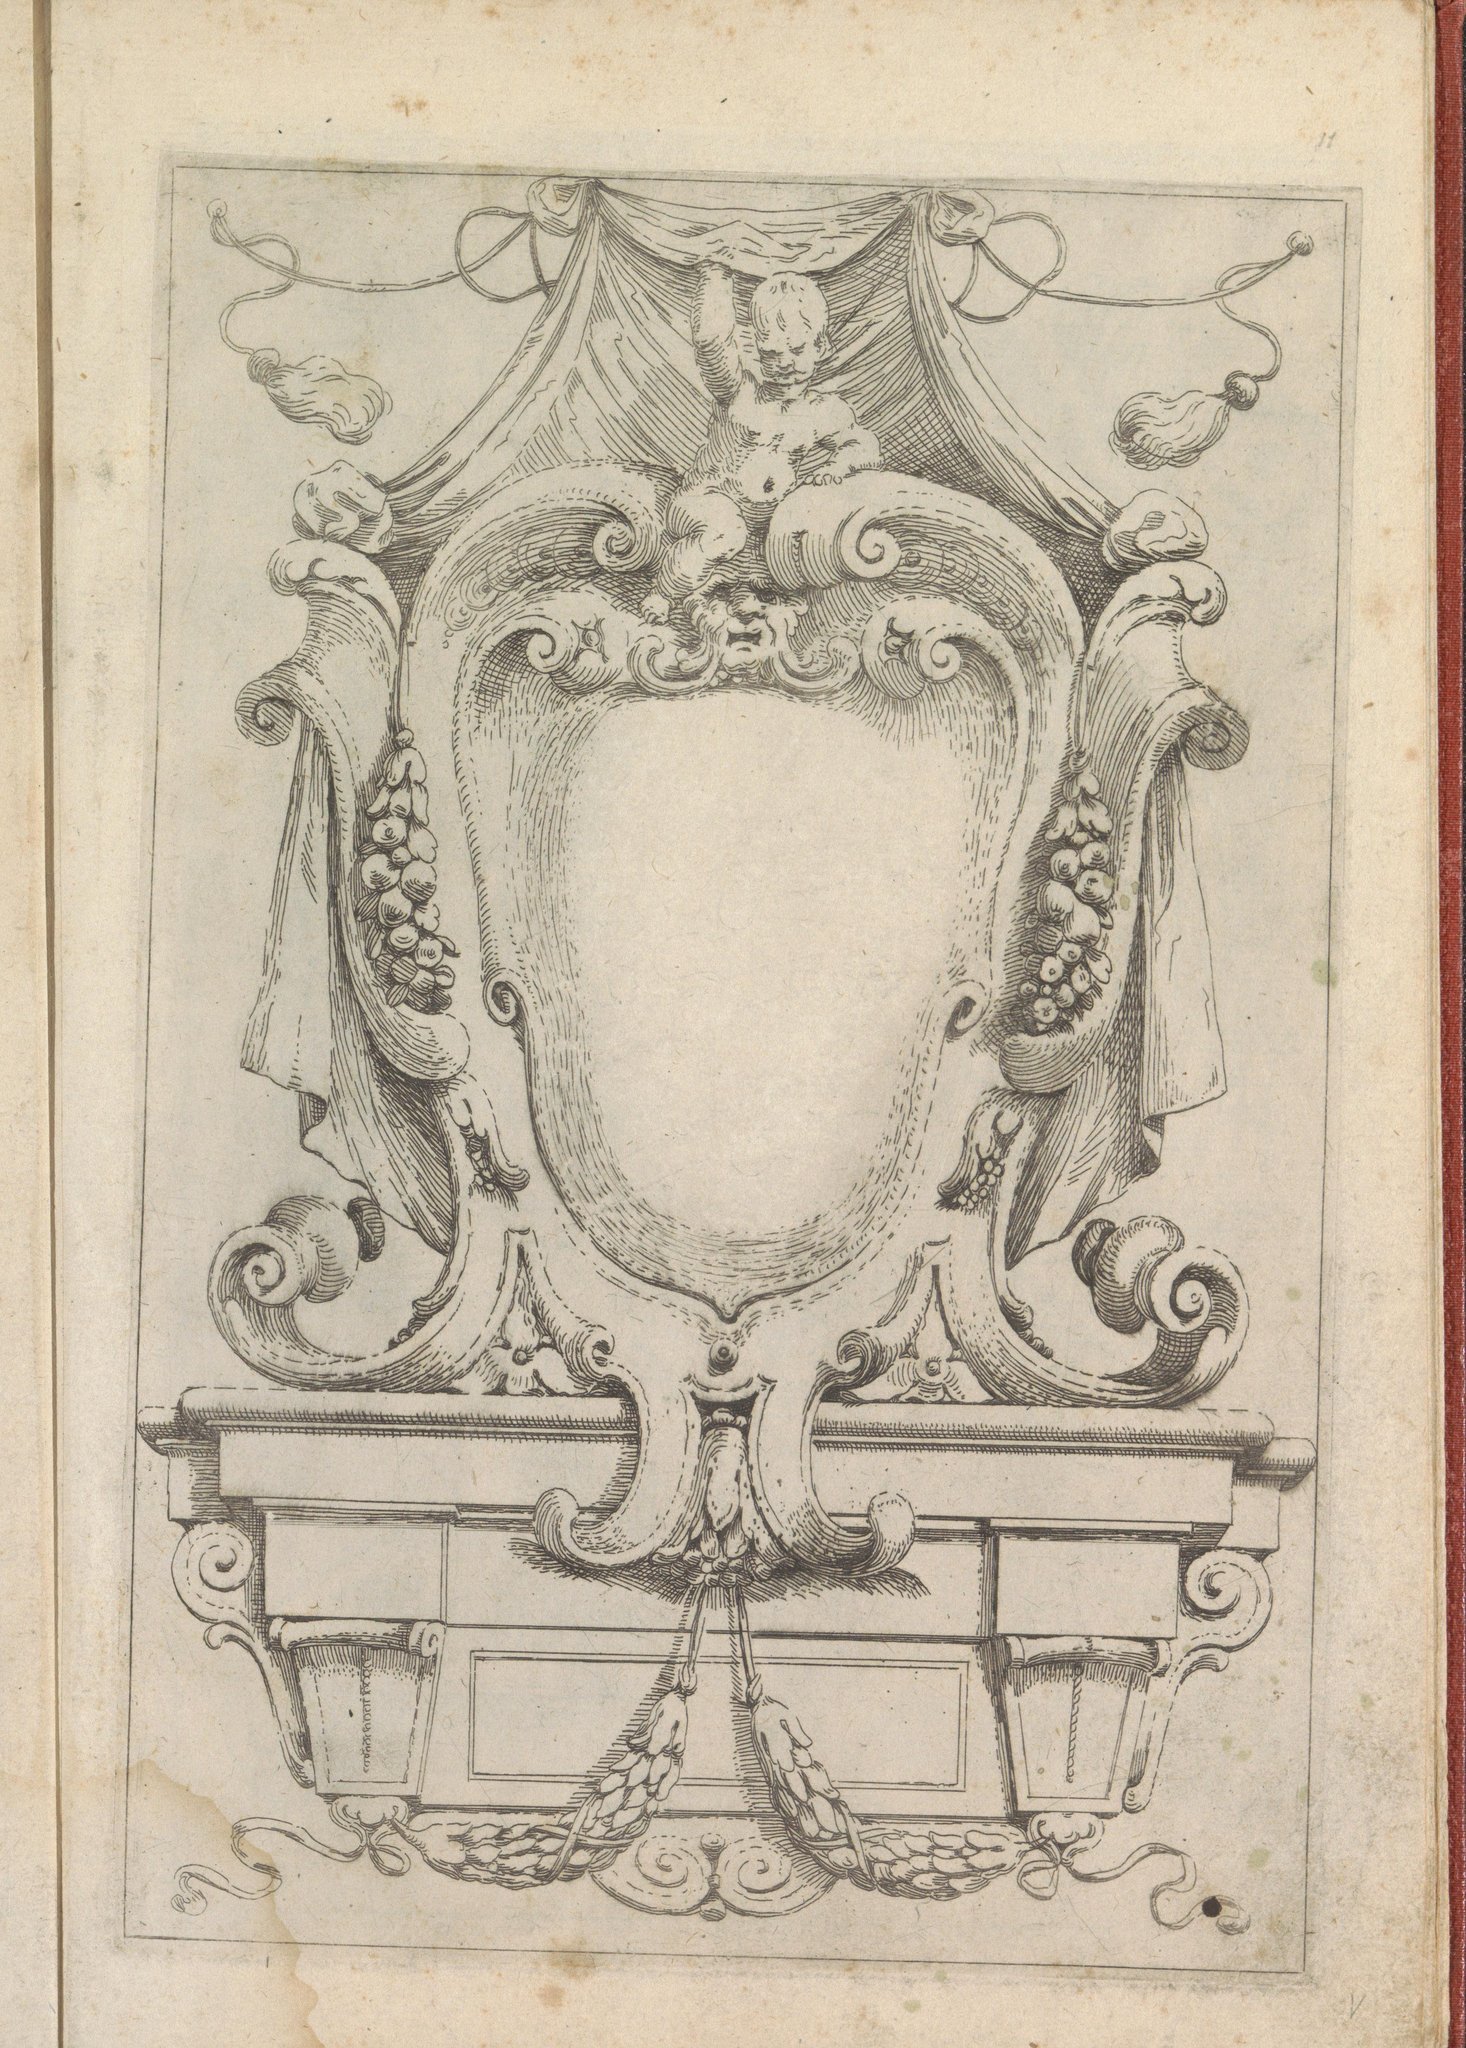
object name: ornament print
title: Cartouche met putto onder gordijn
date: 1636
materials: paper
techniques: etching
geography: bologna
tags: curtains, ornament ~ cartouche, cupids: 'amores', 'amoretti', 'putti'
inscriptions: collector's mark: Lugt 2760, collector's mark: Lugt 2228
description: Een cartouche met bovenop een putto. Boven het cartouche hangt een gordijn met linten. De prent maakt deel uit van een album.